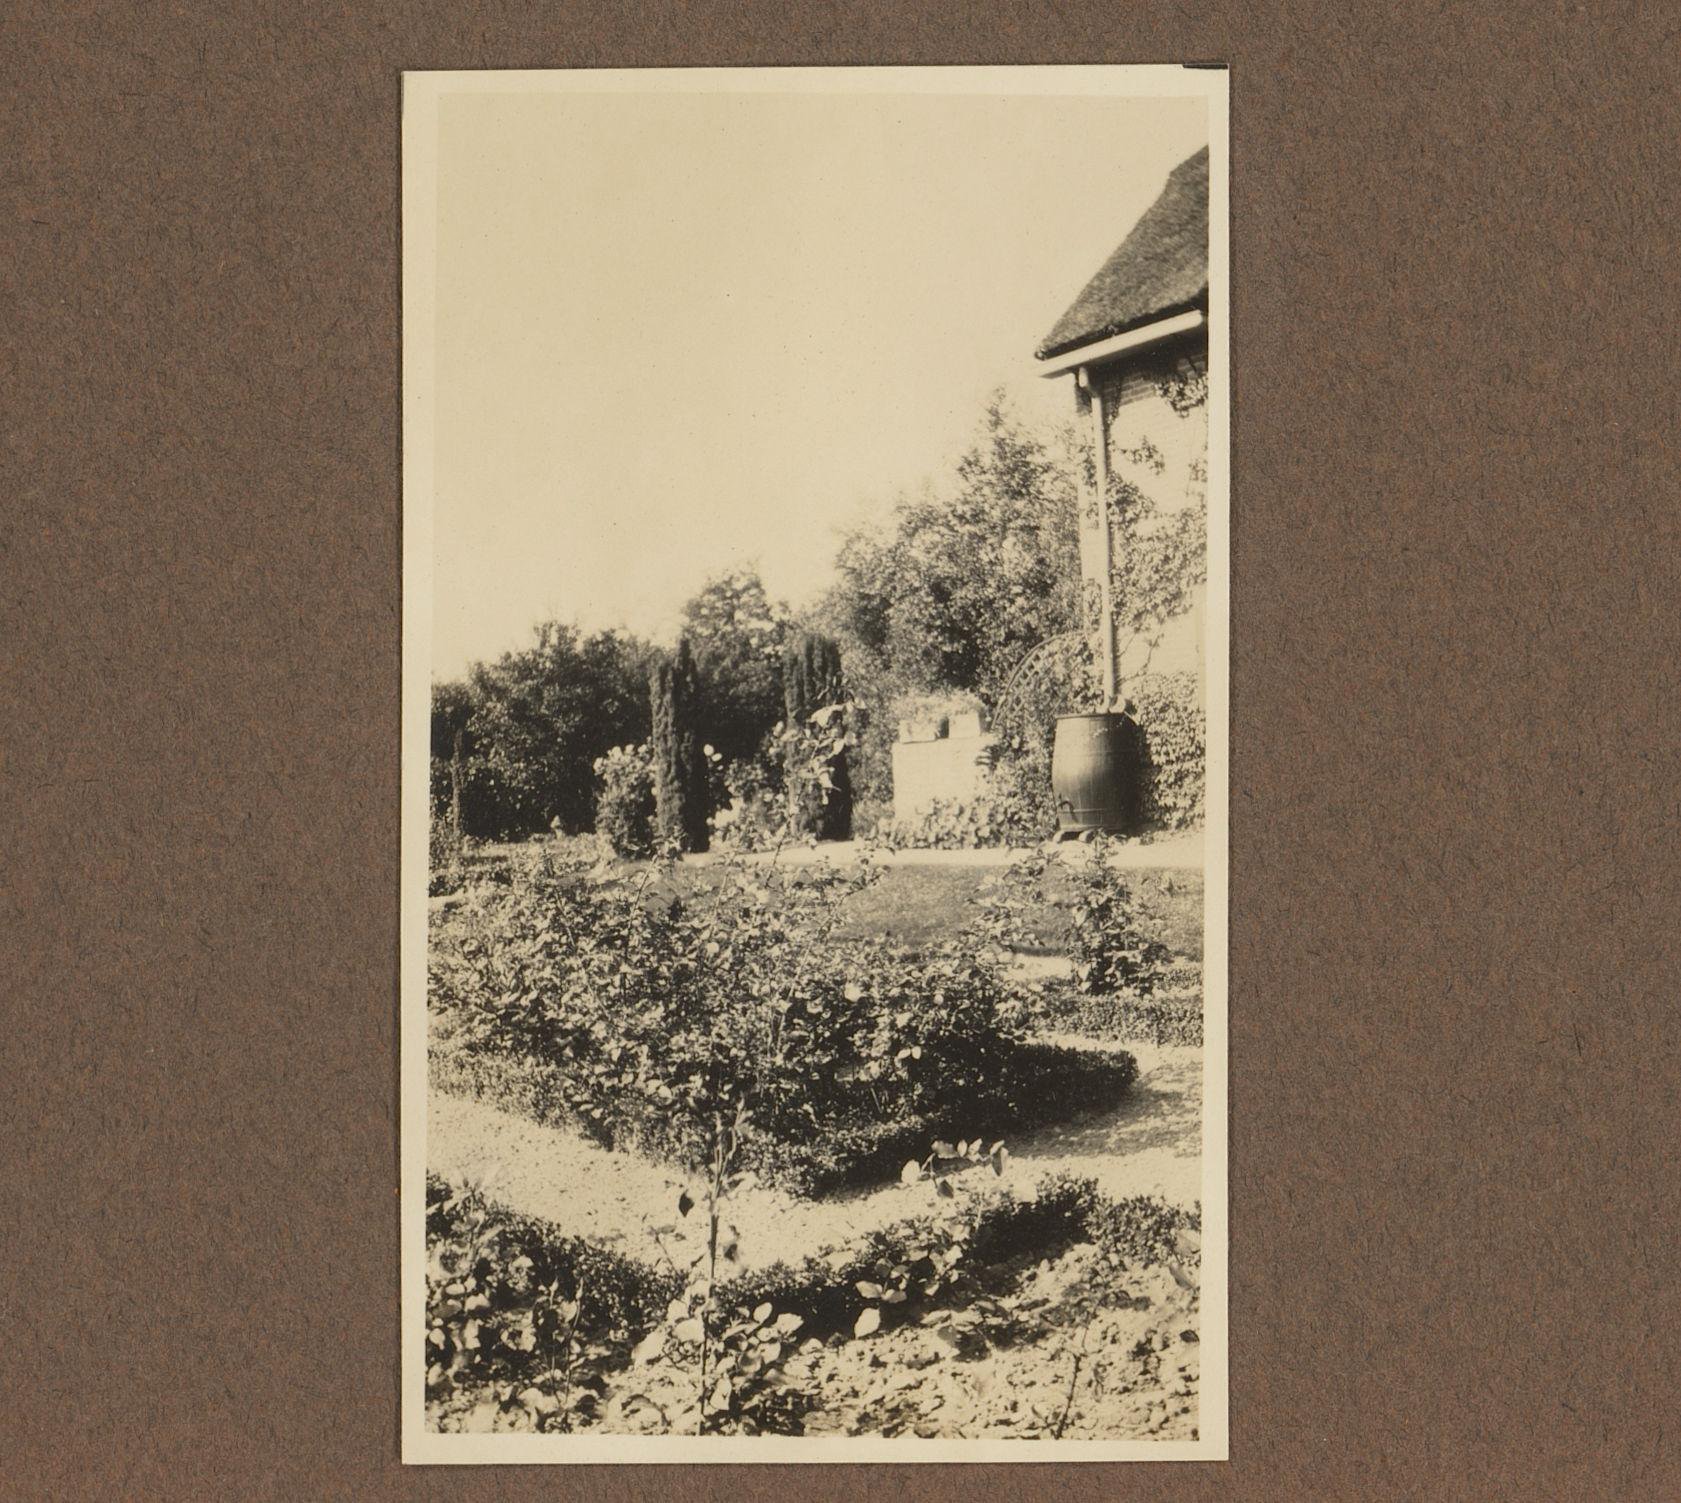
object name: photograph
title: Tuin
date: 1900-1920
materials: photographic support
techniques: photography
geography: netherlands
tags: netherlands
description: Foto op bruin albumblad 57 van familiealbum van Alphons Diepenbrock.